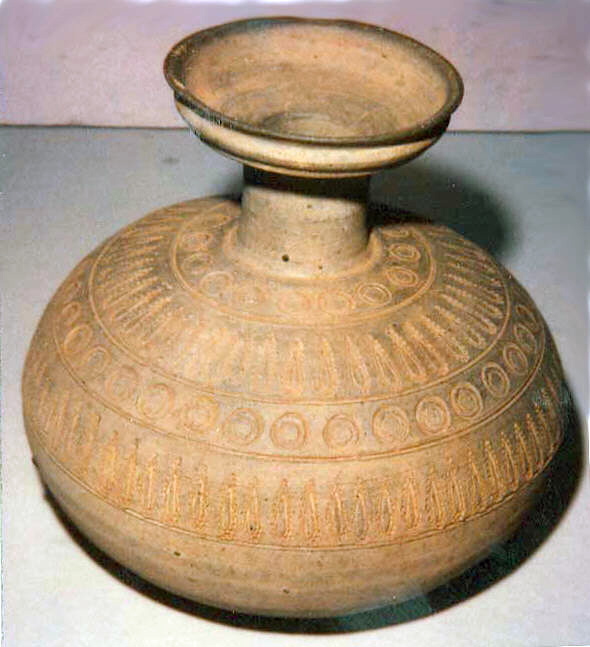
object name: bottle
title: Bottle with Tall Neck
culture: korean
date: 401-700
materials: pottery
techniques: firing